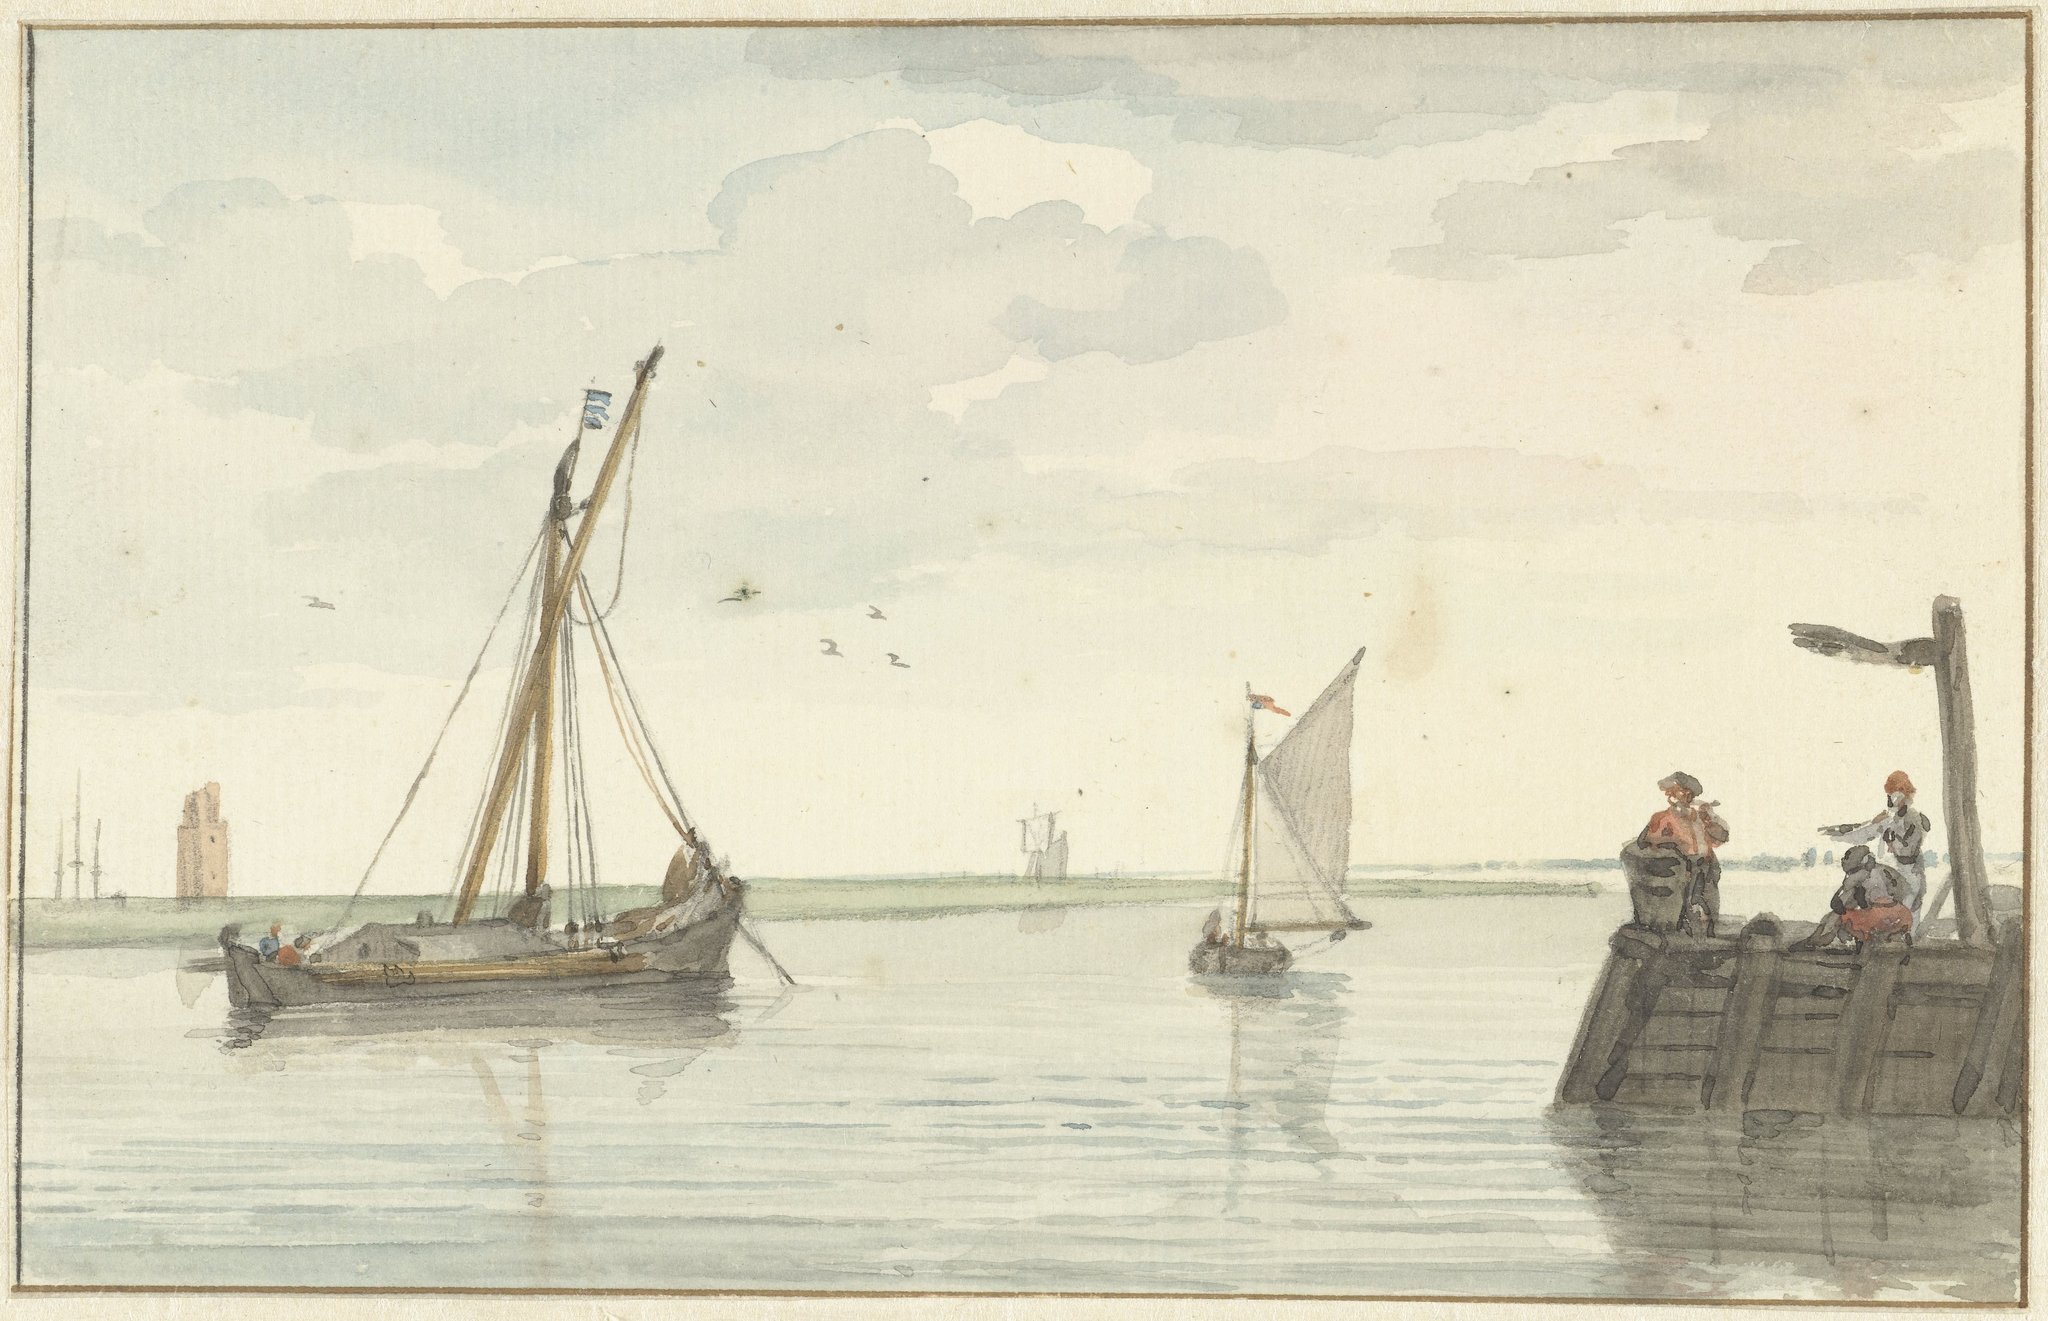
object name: watercolor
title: Het stenen vuurbaken en het havenhoofd van Durgerdam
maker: aert schouman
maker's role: draughtsman, painter, print maker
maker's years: 1710-1792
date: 1756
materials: paper, watercolor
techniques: brush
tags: harbour, lighthouse, lightship, sailing-ship, sailing-boat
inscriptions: inscription: ‘t steene vuerbaken en hooft van Durkerdam 1756’